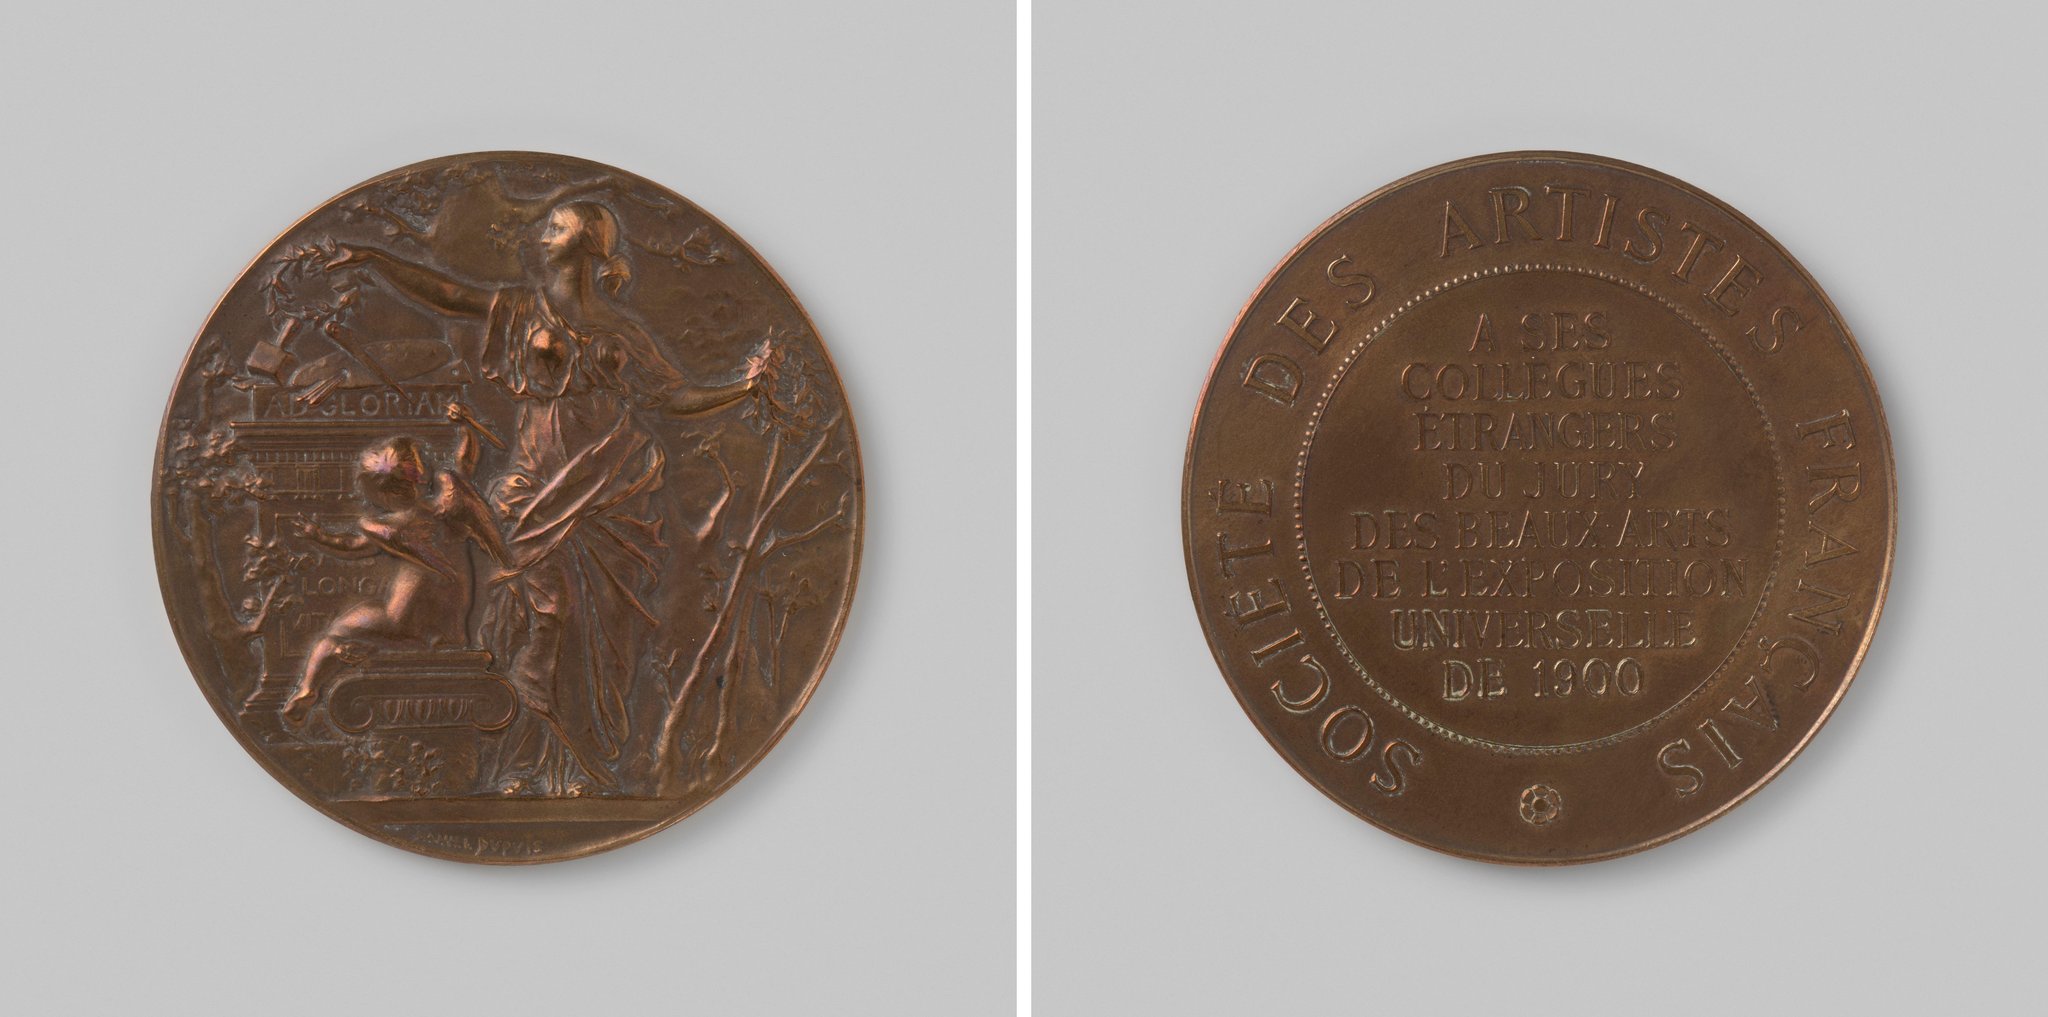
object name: medal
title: Penning uitgereikt aan de buitenlandse juryleden van de wereldtentoonstelling in Parijs, 1900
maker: jean-baptiste daniel-dupuis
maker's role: sculptor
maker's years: 1749-1899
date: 1900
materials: bronze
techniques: striking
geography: france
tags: the hague, amsterdam, bart van hove, paris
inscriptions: signature: ‘DANIEL DUPUIS’, inscription: ‘AD GLORIAM ARS.. LONGA.. VIT..’, mark: ‘BRONZE’, circumscription: ‘SOCIÉTÉ DES ARTISTES FRANÇAIS’, inscription: ‘A SES COLLEGUES ETRANGERS DU JURY DES BEAUX-ARTS DE L'EXPOSITION UNIVERSELLE DE 1900’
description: Bronzen penning. Voorzijde: staande vrouw met in haar beide handen een lauwerkrans. Aan haar voeten, zittende op een pilaar een schrijvende putto. Op de achtergrond bomen, een monument met opschrift en kunstenaarsbenodigdheden. Met signatuur. Keerzijde: opschrift binnen parelrand en omschrift. Met randschrift.